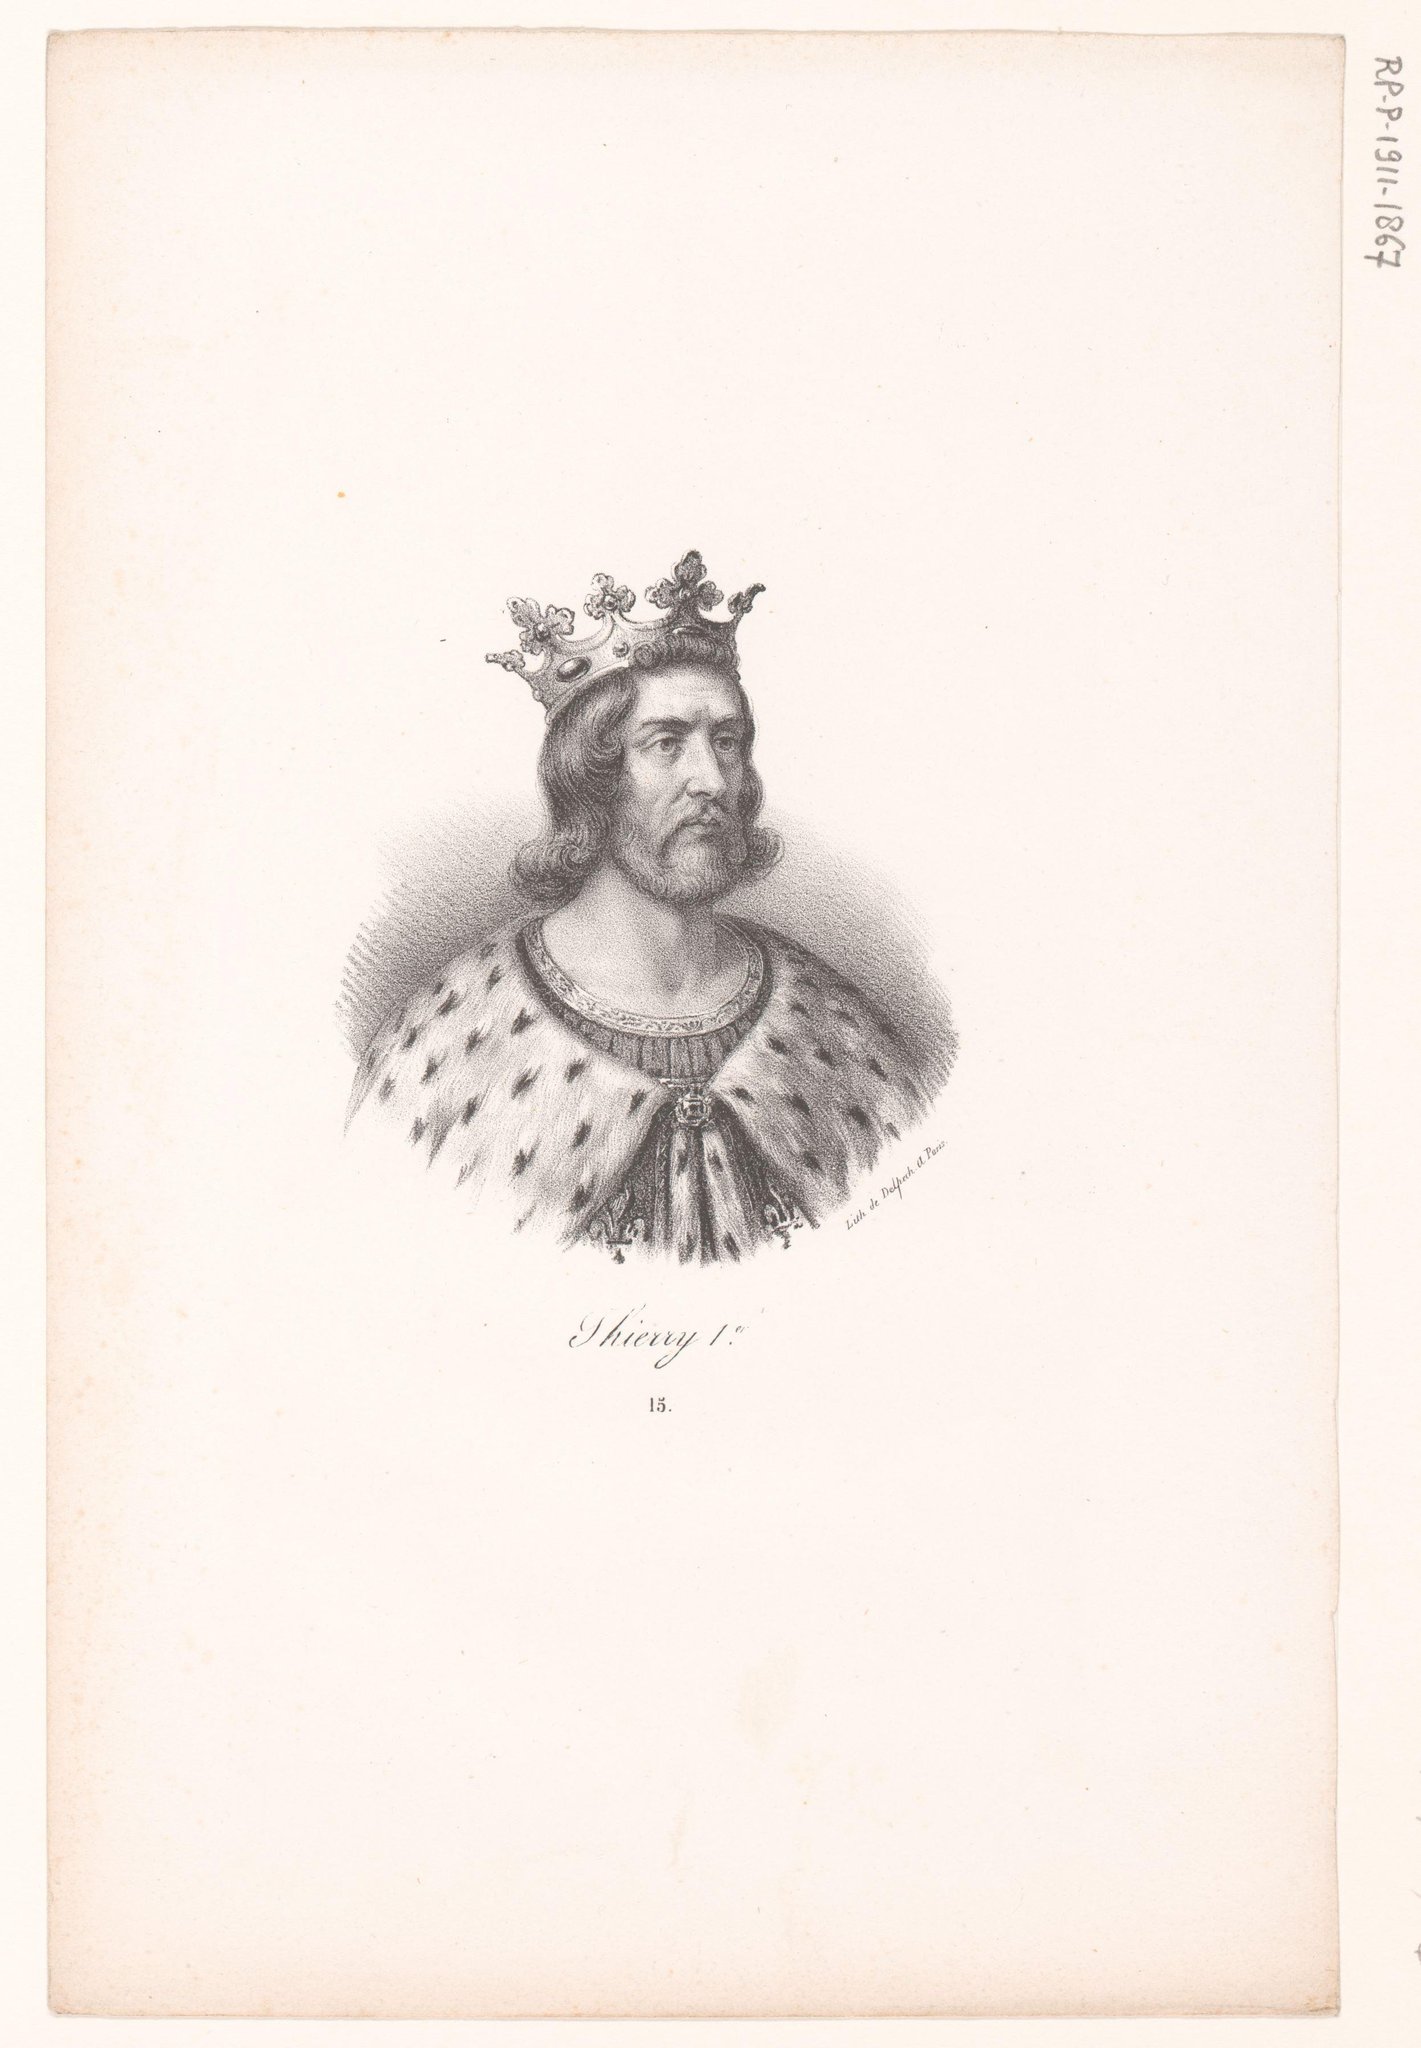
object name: print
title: Thierry 1er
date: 1818-1842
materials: paper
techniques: lithograph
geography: paris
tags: historical persons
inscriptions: collector's mark: Lugt 2228a